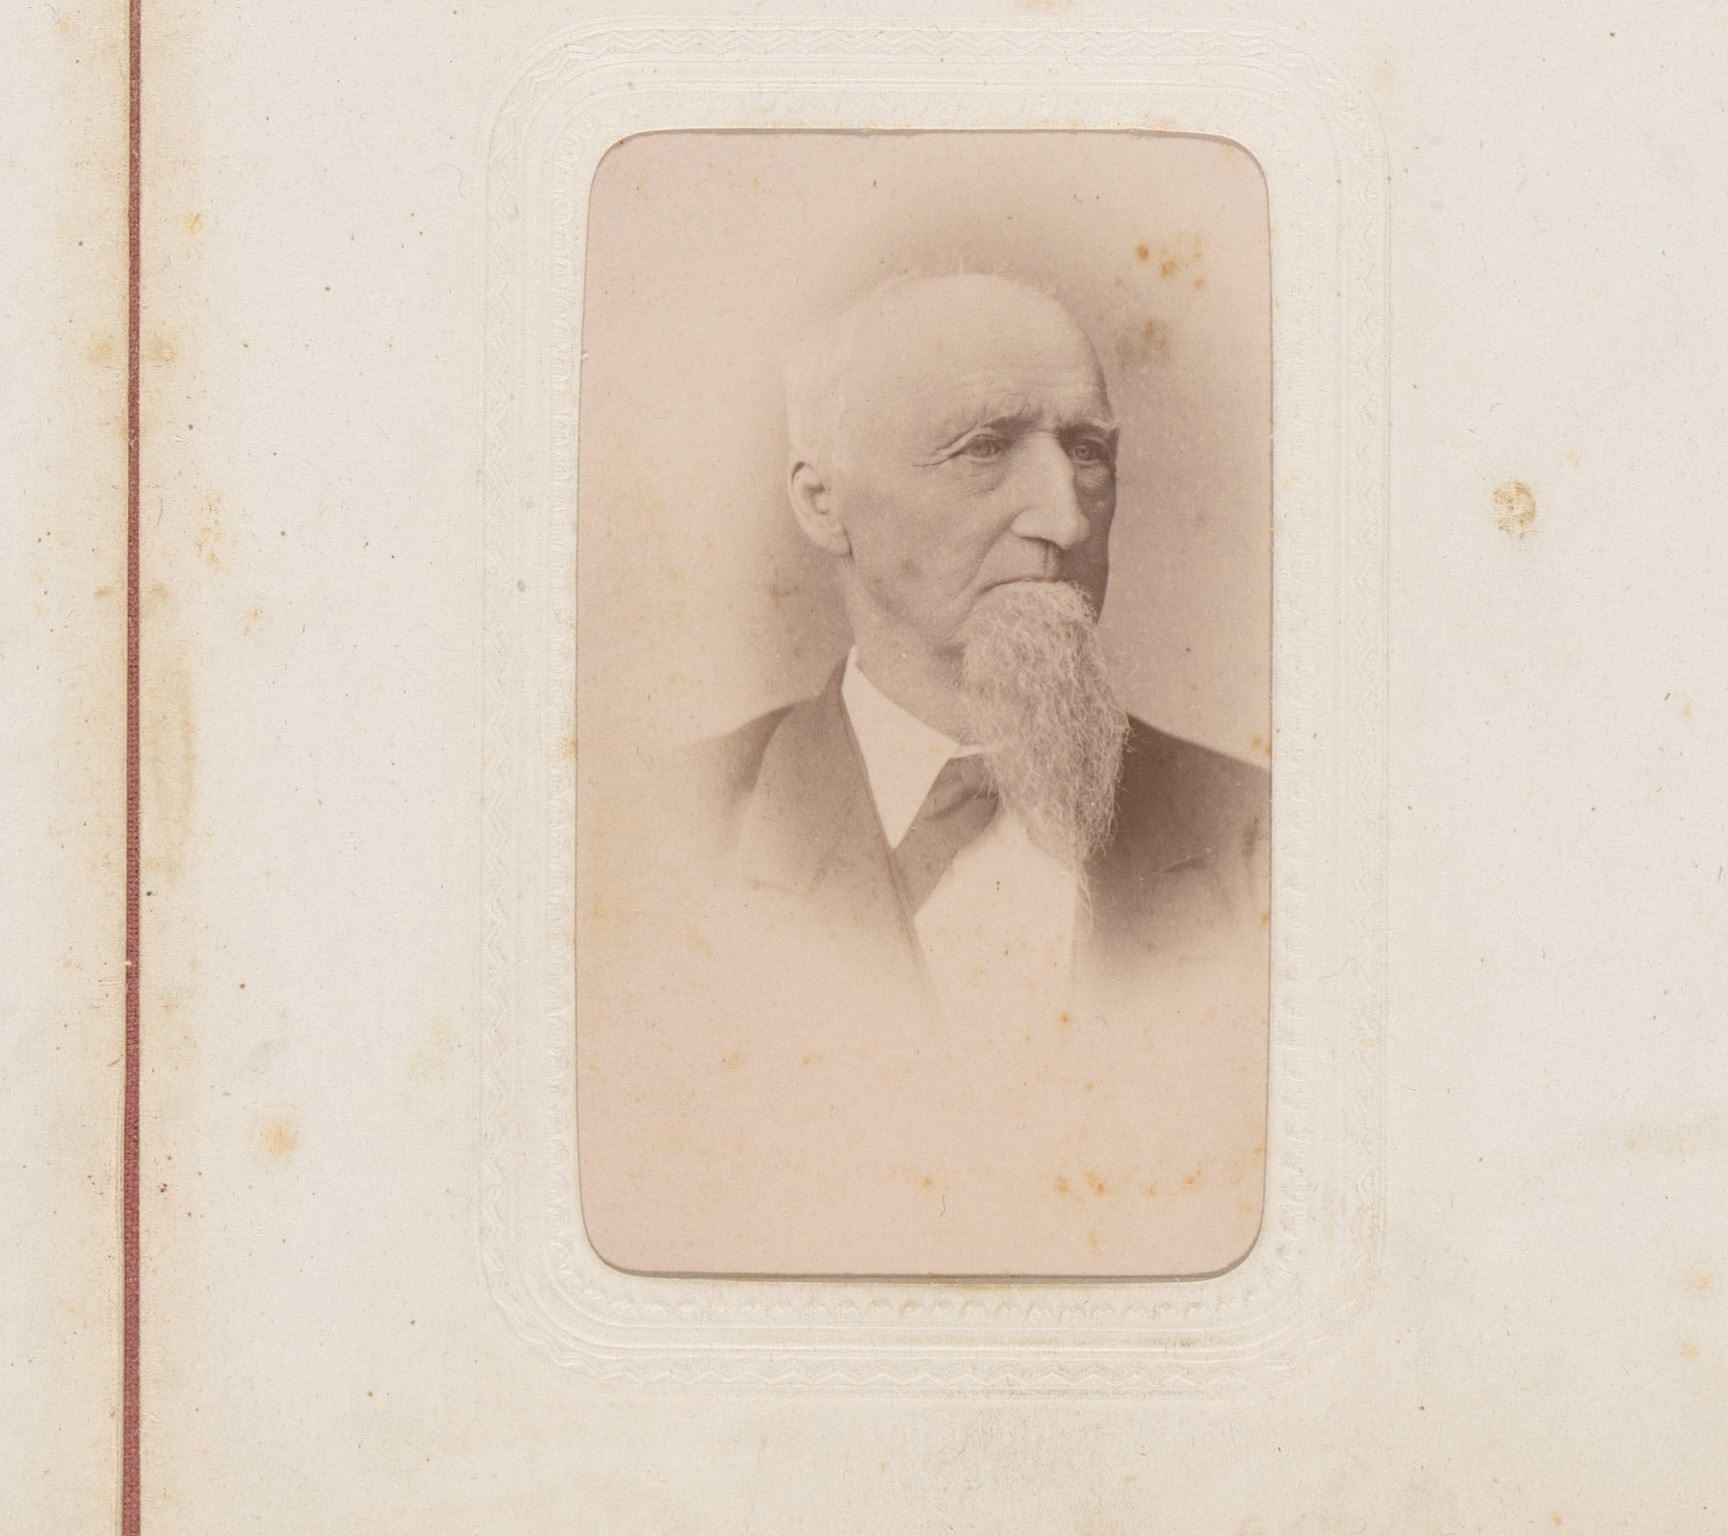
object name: album leaf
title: Portret van een man met baard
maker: a.h. johannson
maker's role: fotograaf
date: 1884-1900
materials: cardboard, photographic support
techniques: albumen print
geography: niesky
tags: historical persons, beard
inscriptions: inscription: ‘Atelier/ für / PHOTOGRAPHIE/ von./ A.H. Johannson/ Niesky/ Oedernitzer-Str. 10./ 1884./ Die Platte bleibt reservirt./ Von umstehender Aufnahme/ künnen Bilder bis zur Lebens/ (...)’